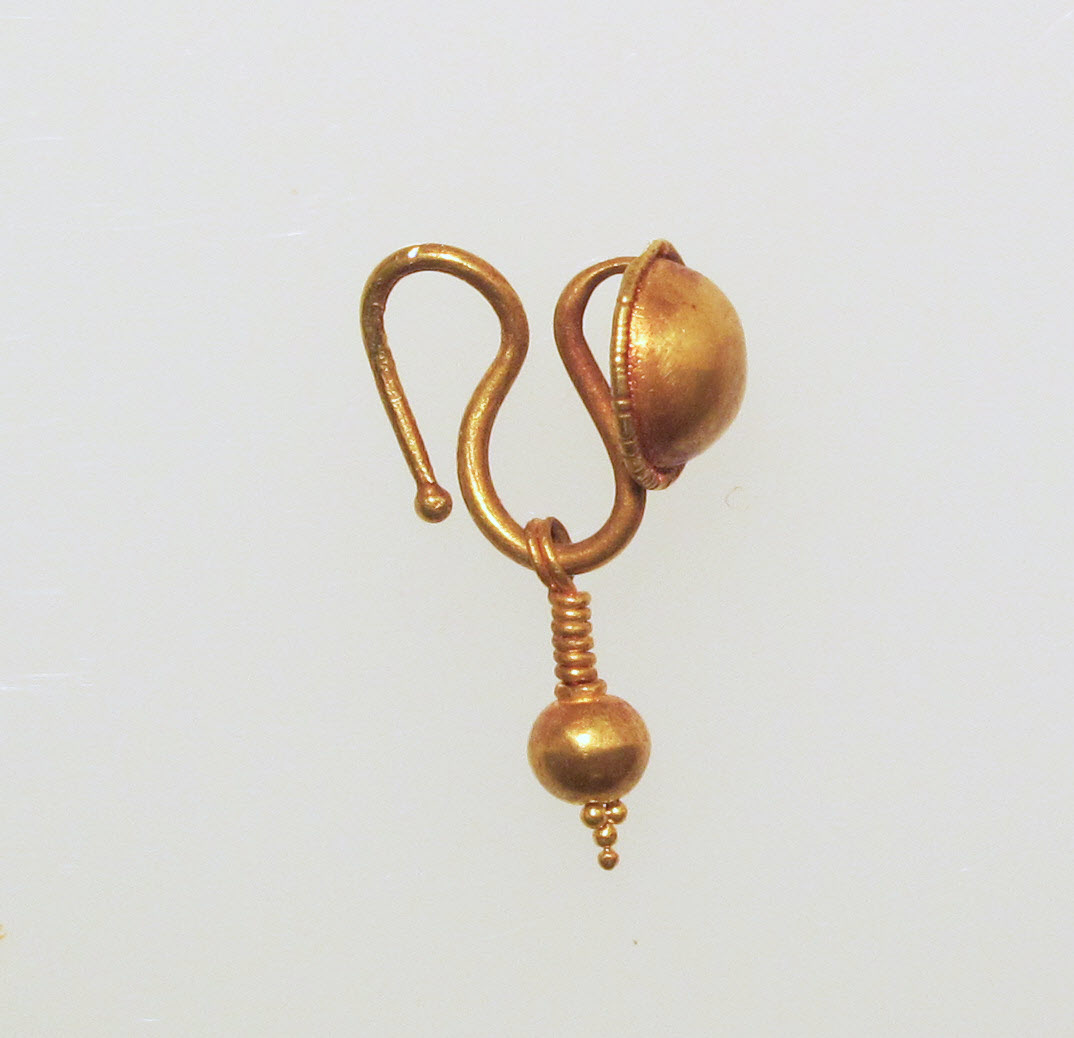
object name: earring hook type with disc and beaded rim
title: Earring-hook type with disc and beaded rim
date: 7000 BCE-330 CE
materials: gold